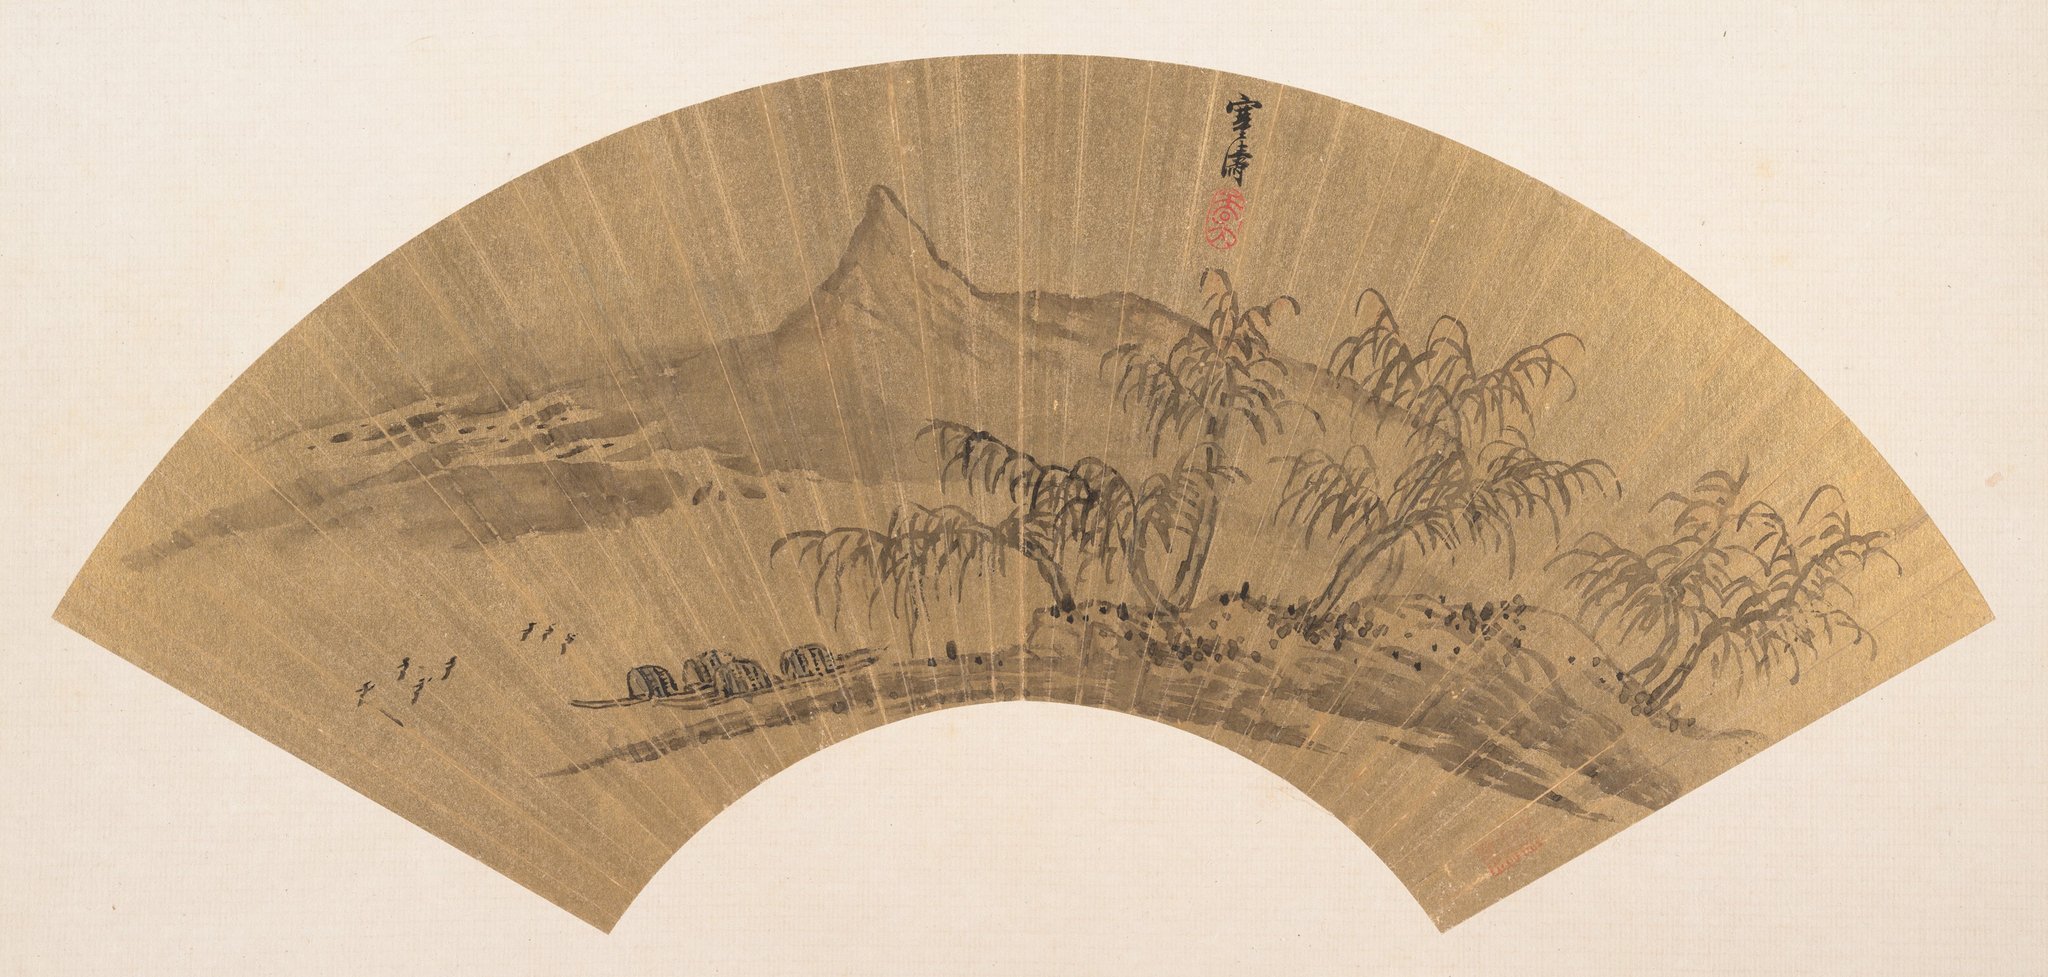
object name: folding fan mounted a an album leaf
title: Riverscape with moored boats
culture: chinese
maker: wu shantao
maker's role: artist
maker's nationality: chinese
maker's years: 1624-1710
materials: gold, ink, paper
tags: mountains,landscapes,boats